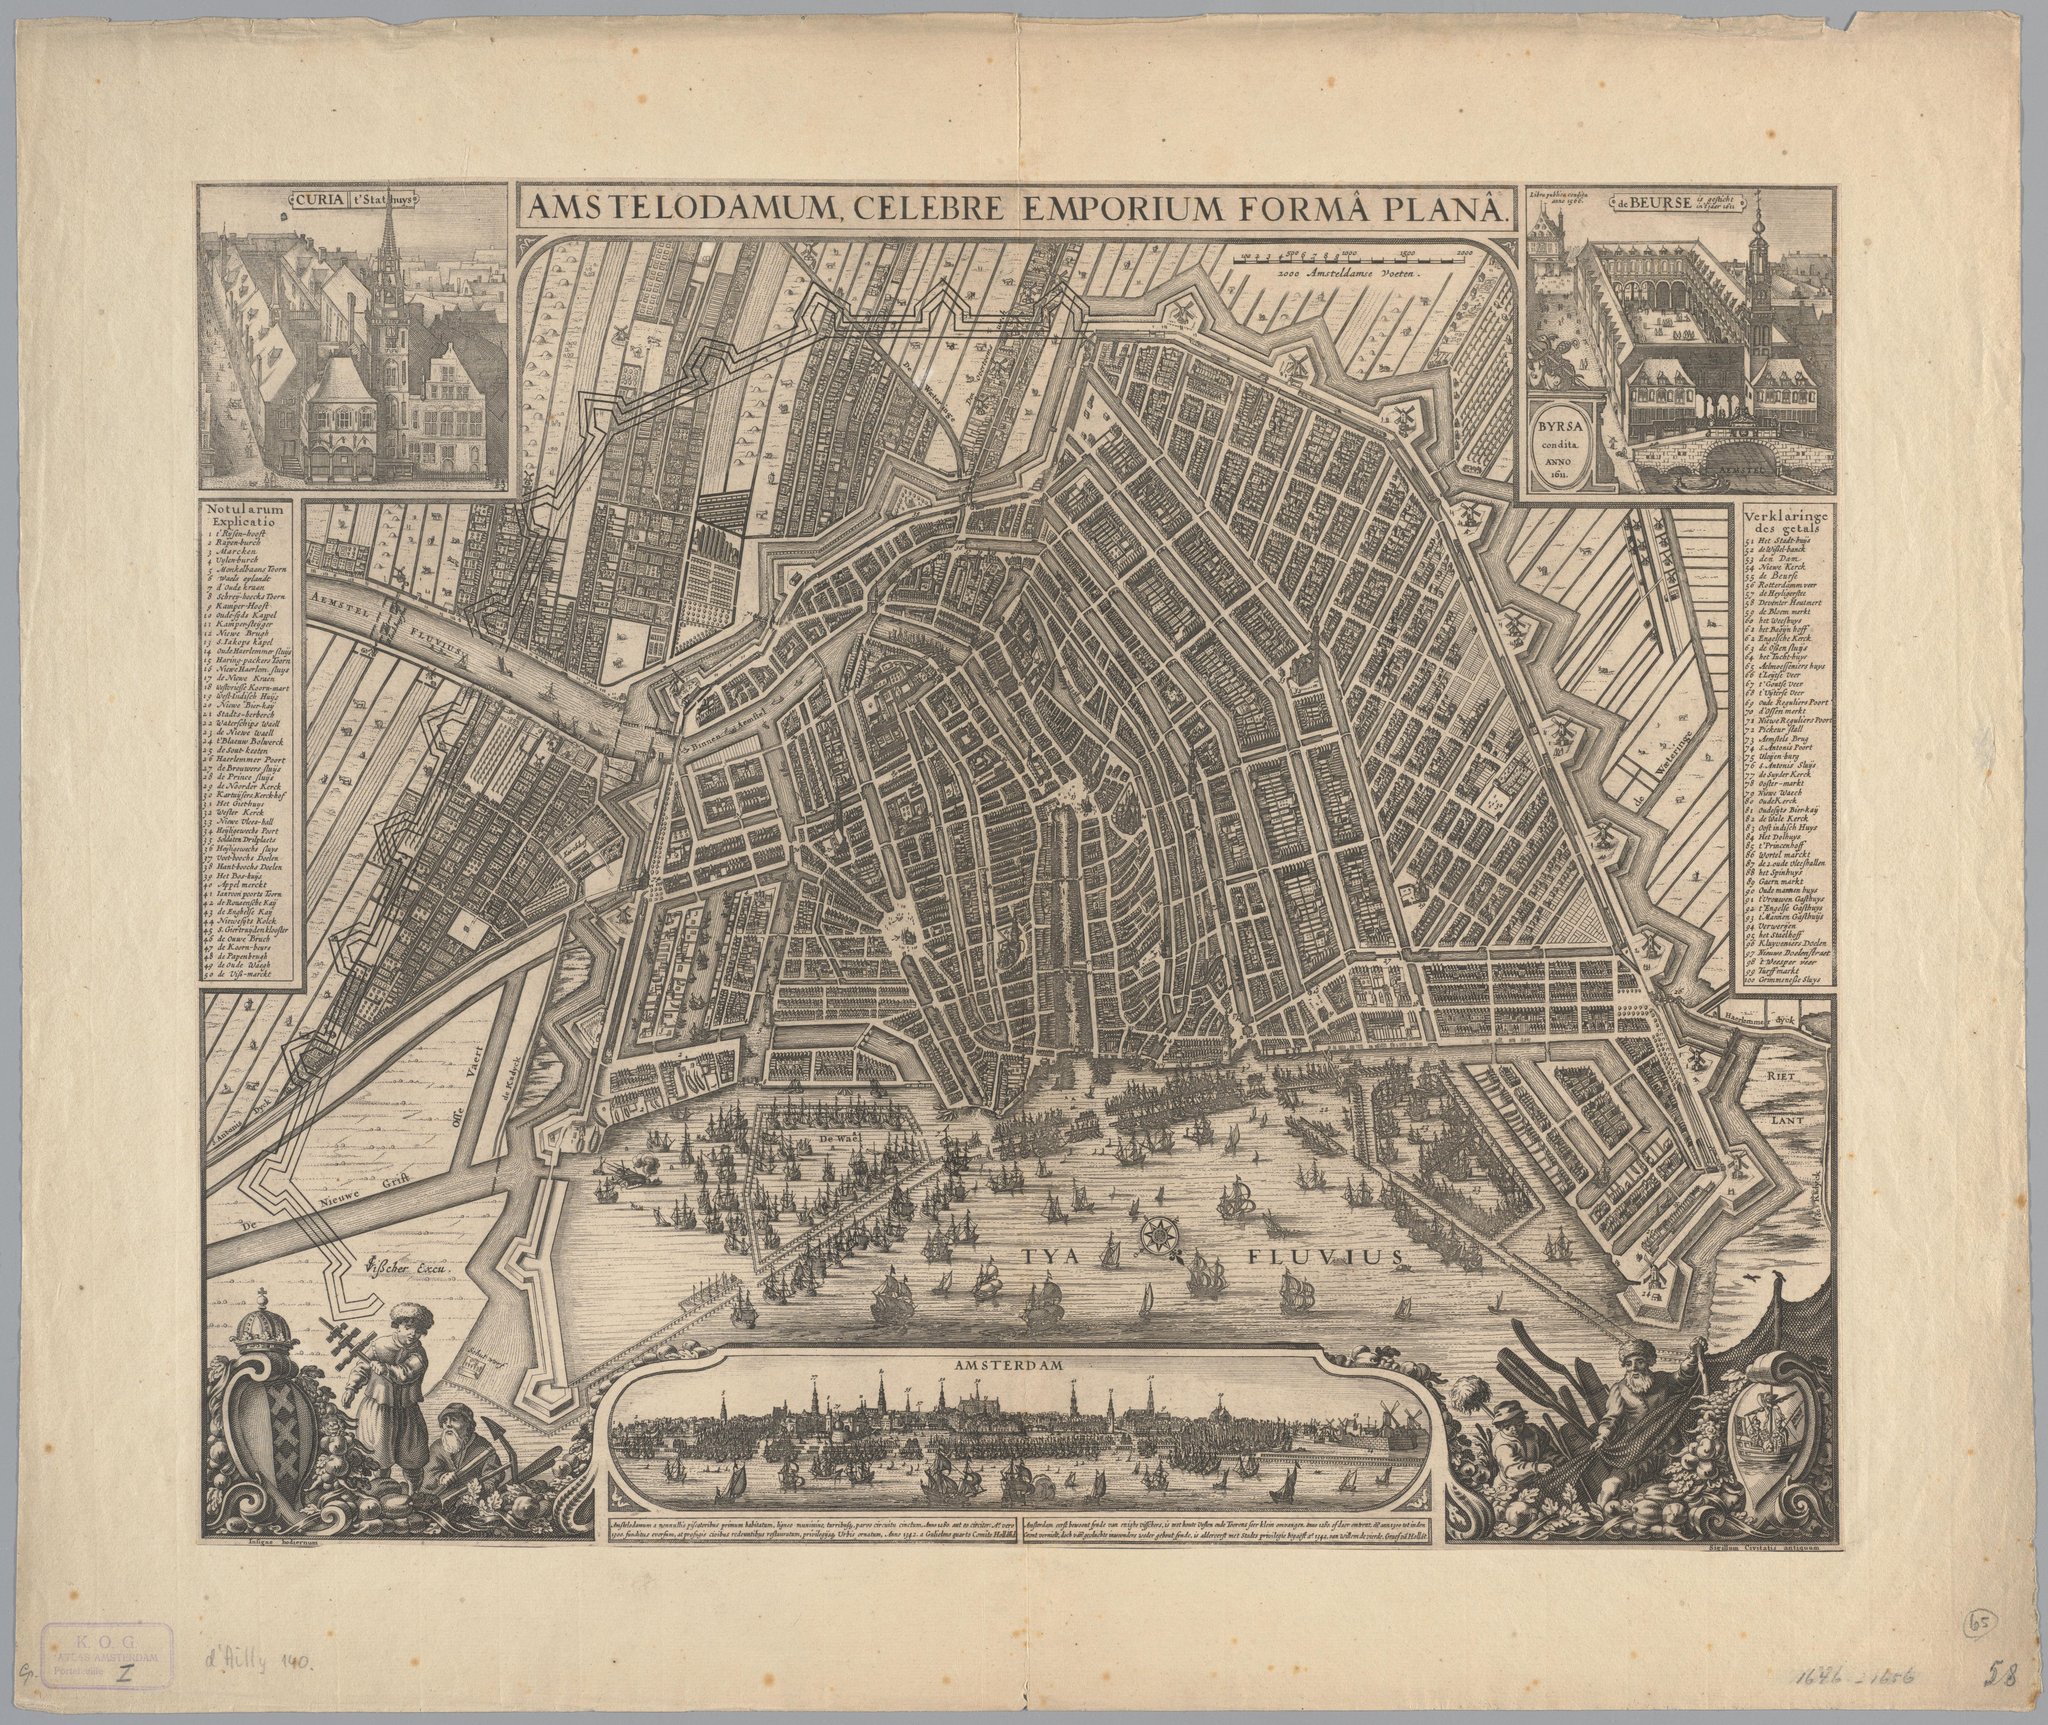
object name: print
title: Amstelodamum, celebre emporium formâ planâ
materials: paper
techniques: engraving, etching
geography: northern netherlands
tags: coat of arms (as symbol of the state, etc.) (+ city; municipal), stock exchange, stock-market, townhall, seaman, parts of ship's exterior: anchor, maps of cities, prospect of city, town panorama, silhouette of city, amsterdam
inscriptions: collector's mark: Lugt 1641b